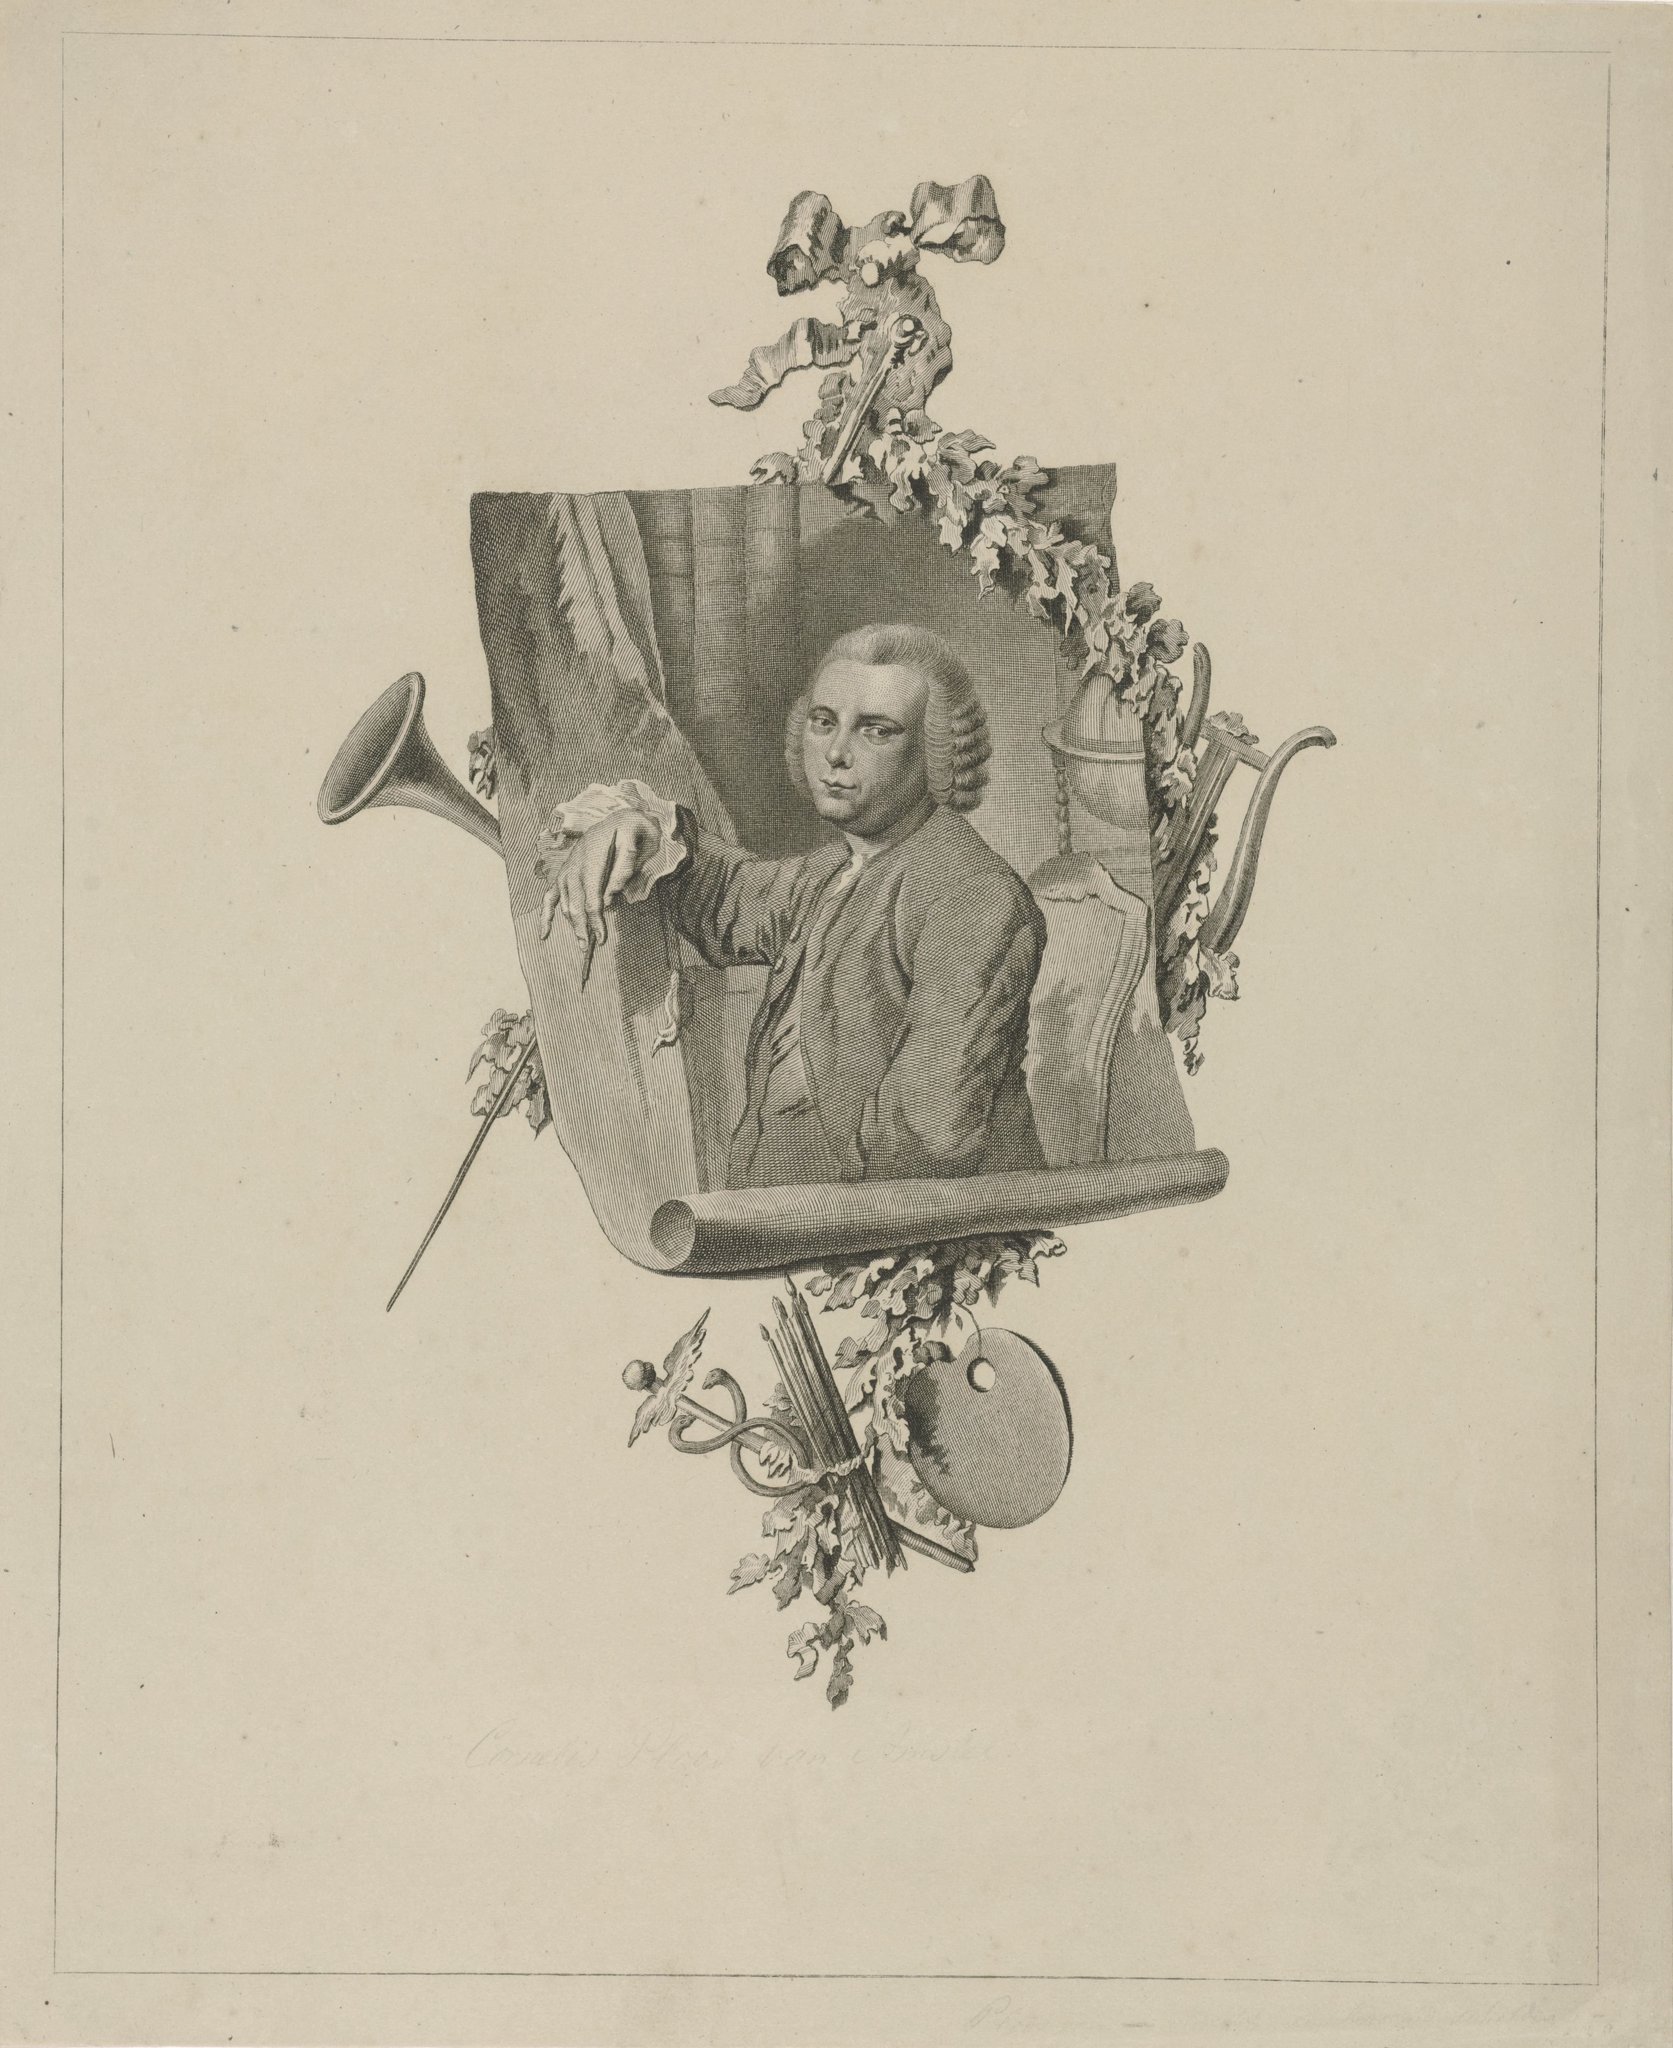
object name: print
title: Portret van Cornelis Ploos van Amstel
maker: noach van der meer (ii)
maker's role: draughtsman, print maker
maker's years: 1741-1822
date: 1751-1798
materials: paper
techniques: etching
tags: amsterdam, print maker, draughtsman, cornelis ploos van amstel, historical persons, portrait, self-portrait of graphic artist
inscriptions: collector's mark: Lugt 2228, collector's mark: Lugt 2760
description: Portret van graveur en verzamelaar Cornelis Ploos van Amstel. Achter het portret loofwerk met een trompet en een lier. Onderaan een palet, penselen en een caduceus.